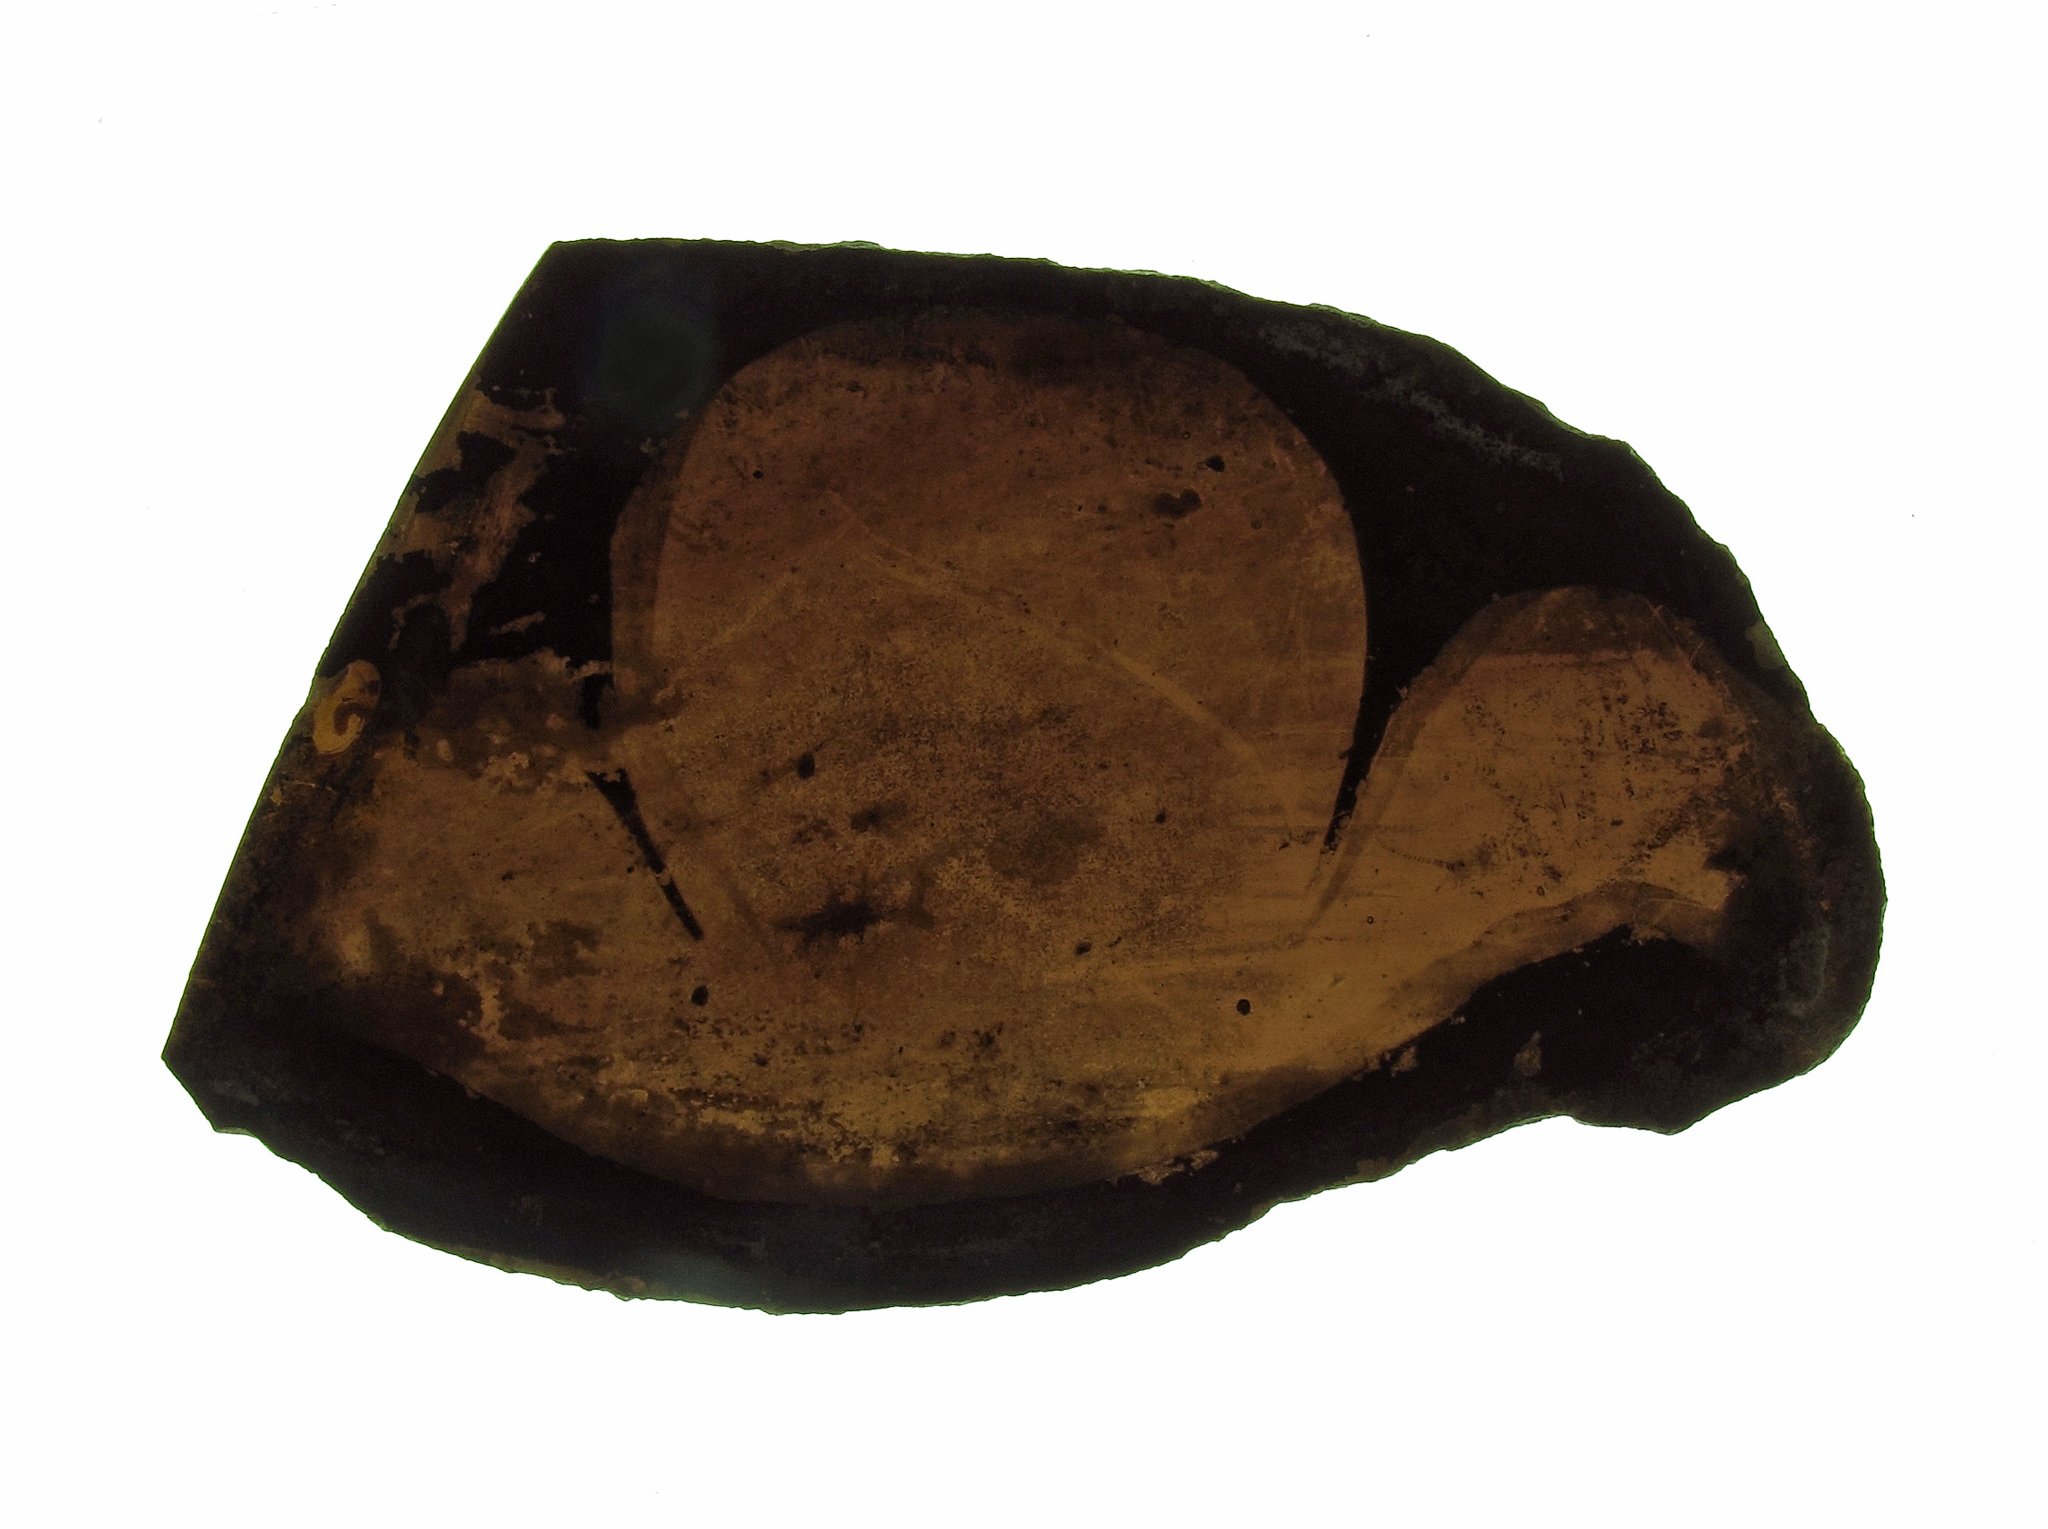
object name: fragment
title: Glass Fragment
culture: european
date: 1201-1400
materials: glass, metal